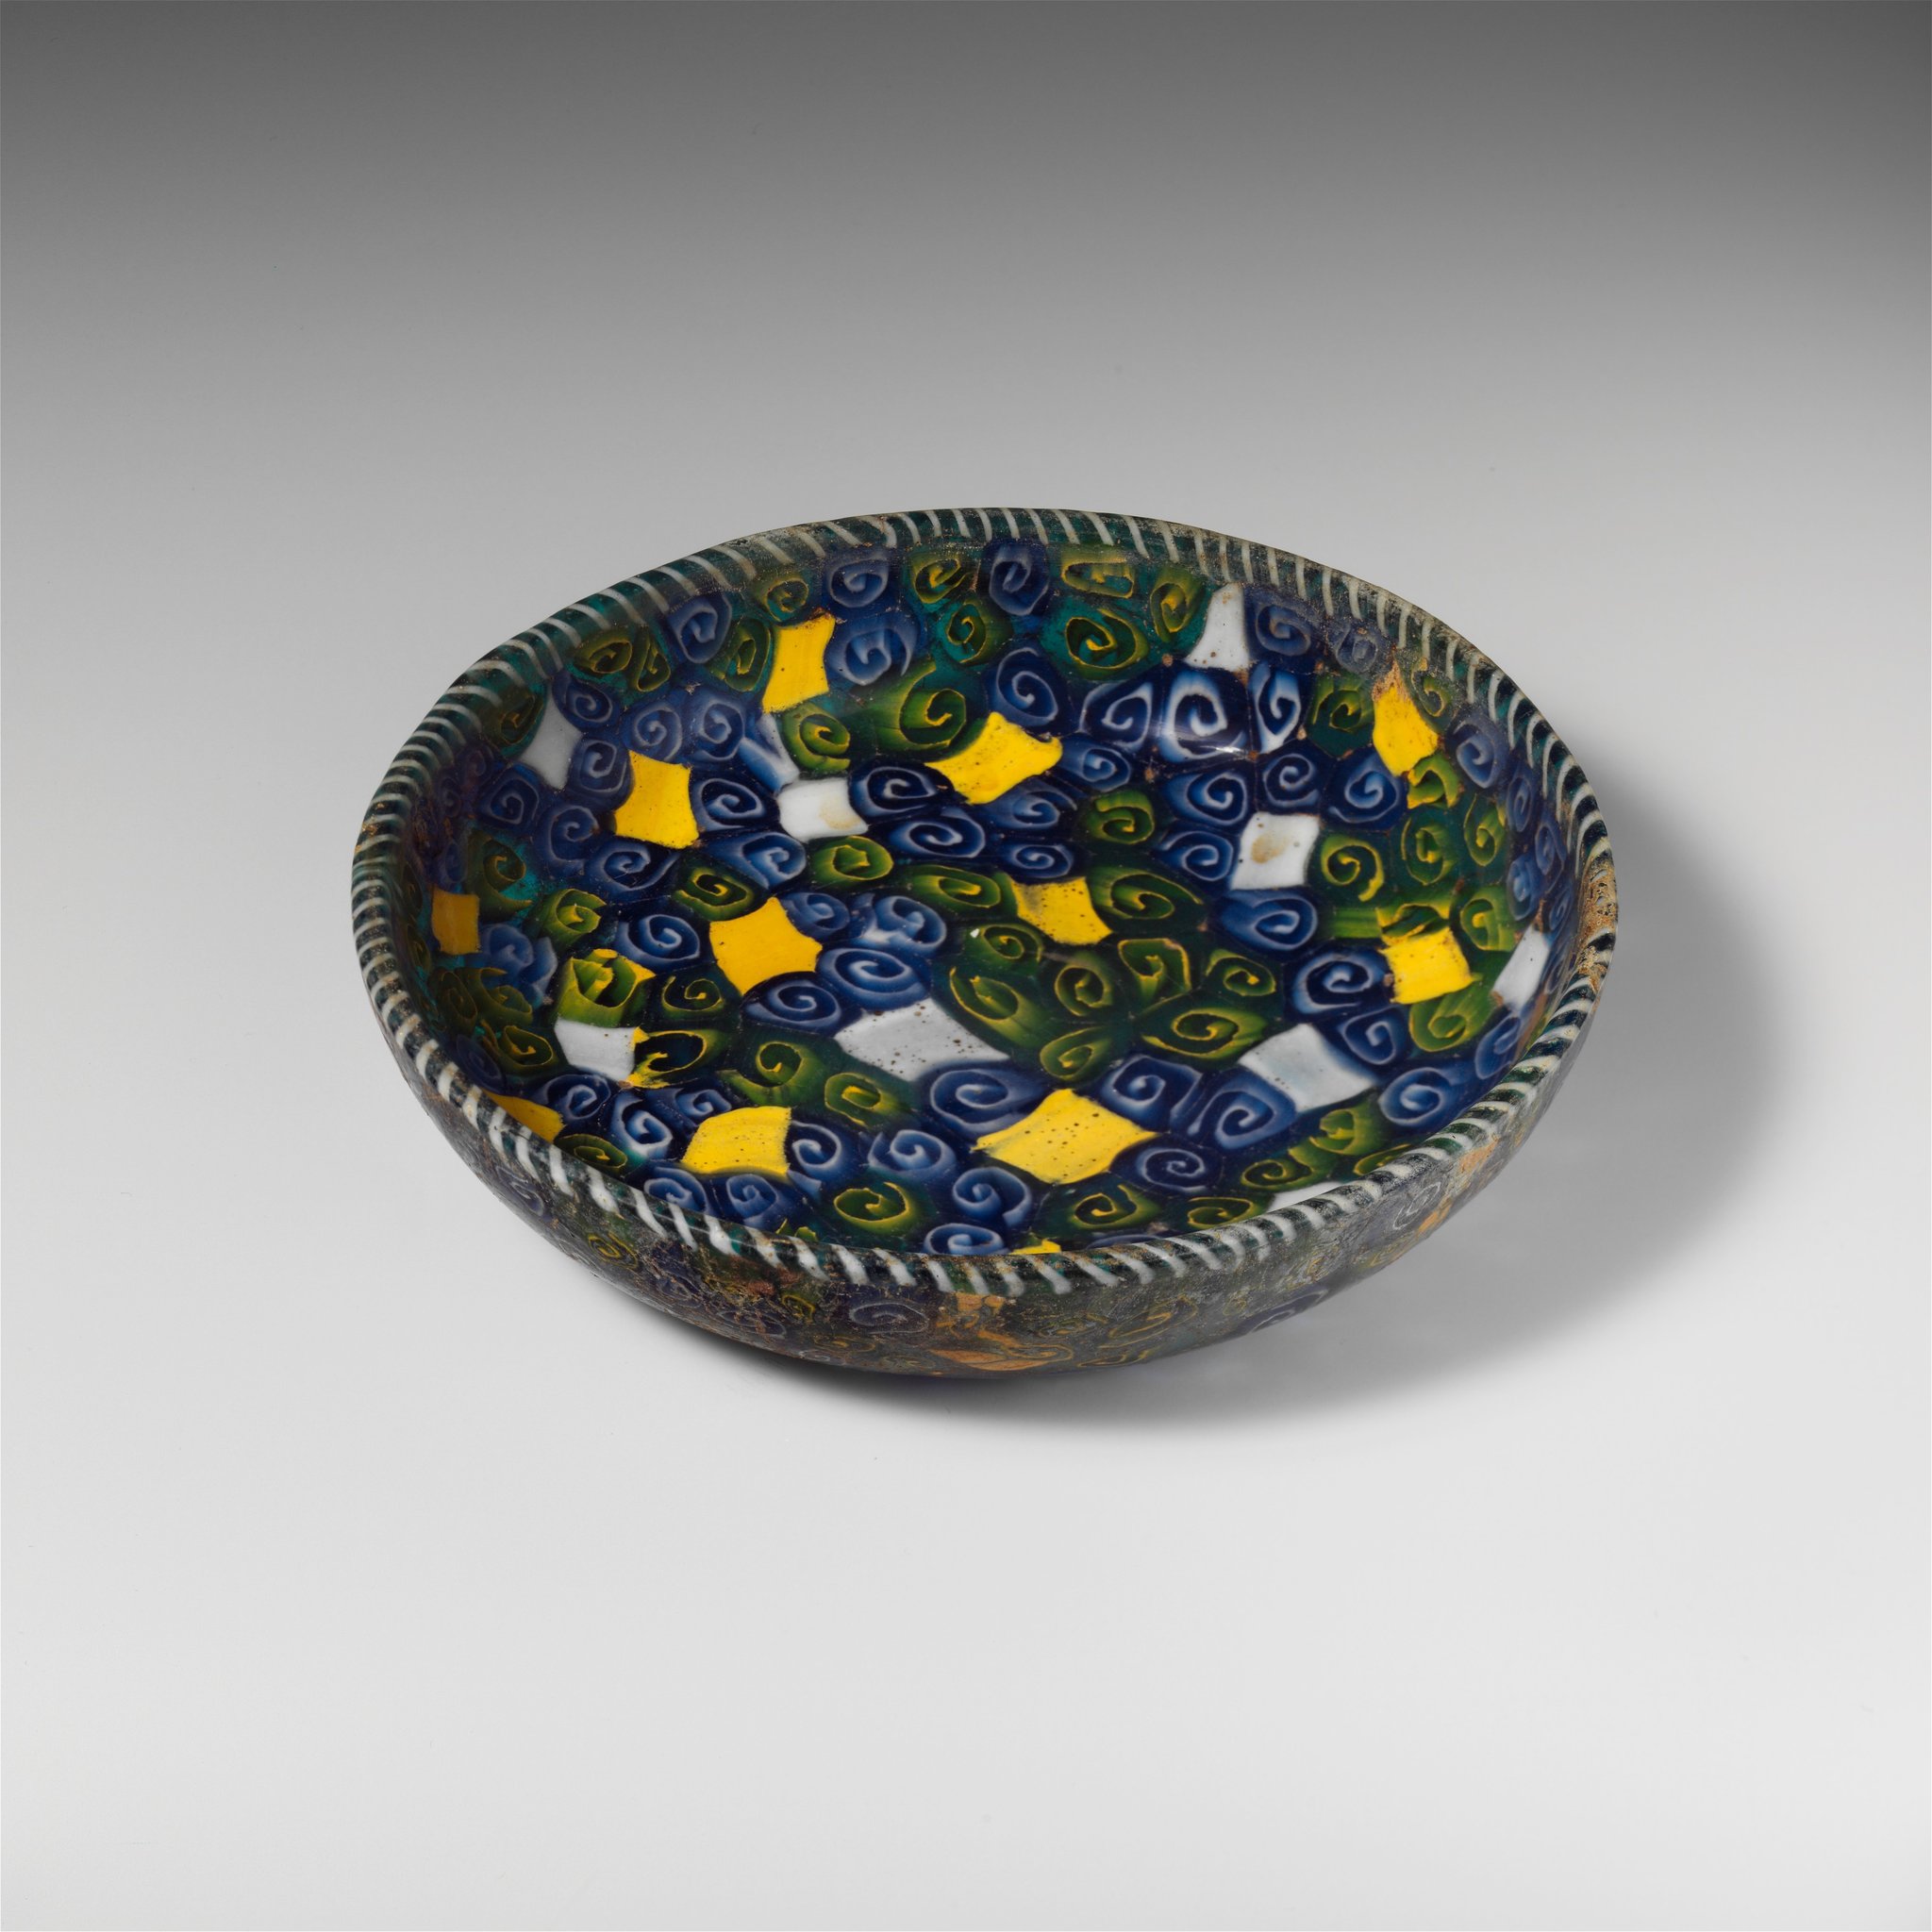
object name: bowl, mosaic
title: Glass mosaic dish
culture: greek, eastern mediterranean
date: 200-35 BCE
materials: glass